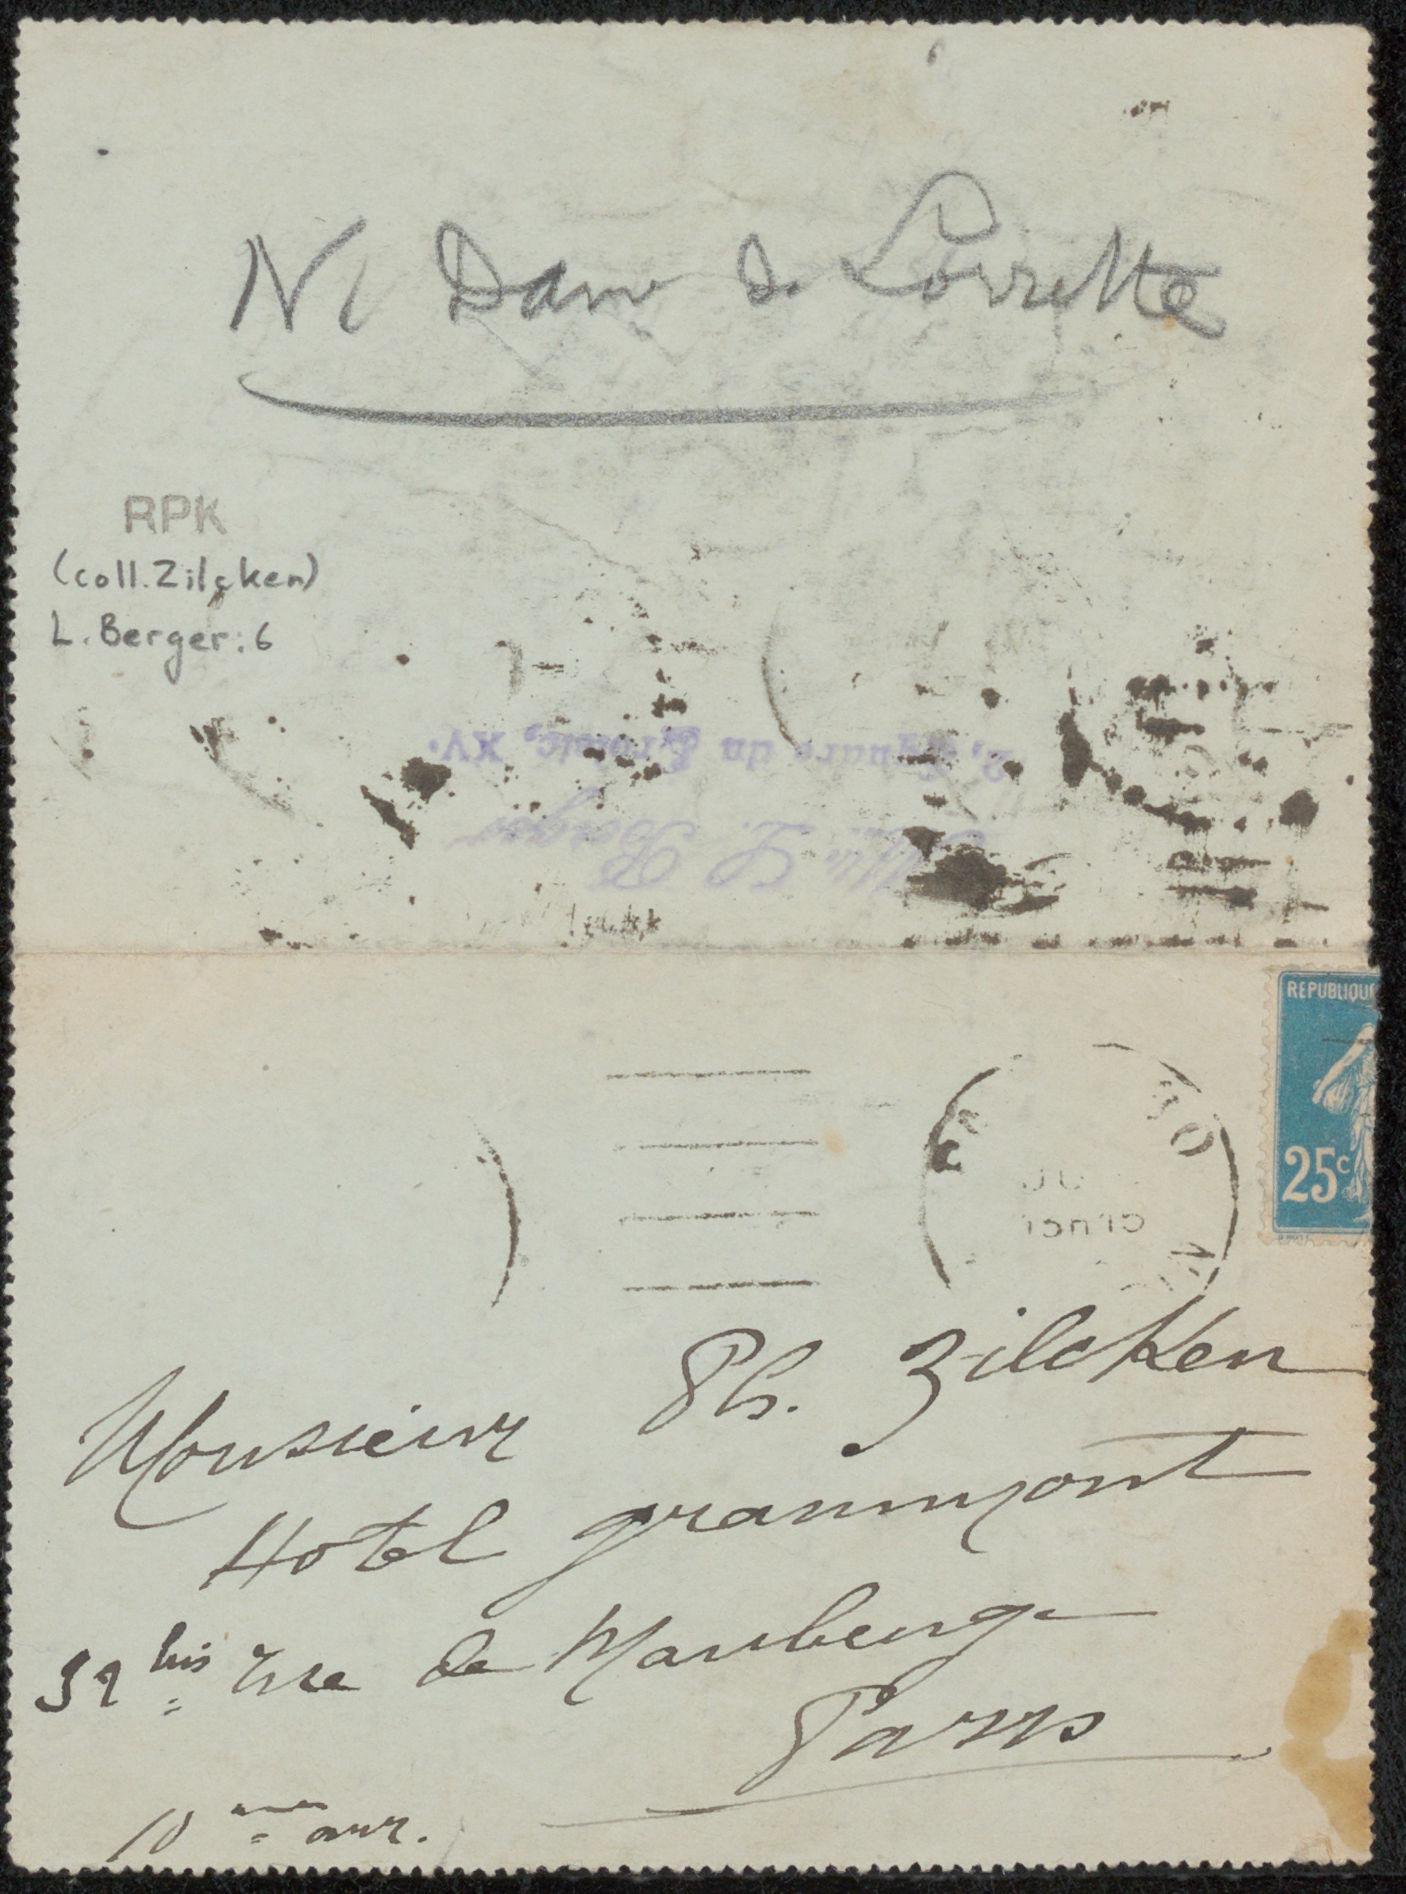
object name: letter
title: Brief aan Philip Zilcken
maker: lya berger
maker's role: schrijver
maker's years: 1877-1941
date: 1923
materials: ink, paper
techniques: pen, writing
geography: paris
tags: the hague, painter, philip zilcken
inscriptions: address: ‘Mlle. L. Berger/ 2, Square du Croisic, XVe’, collector's mark: ‘RPK’